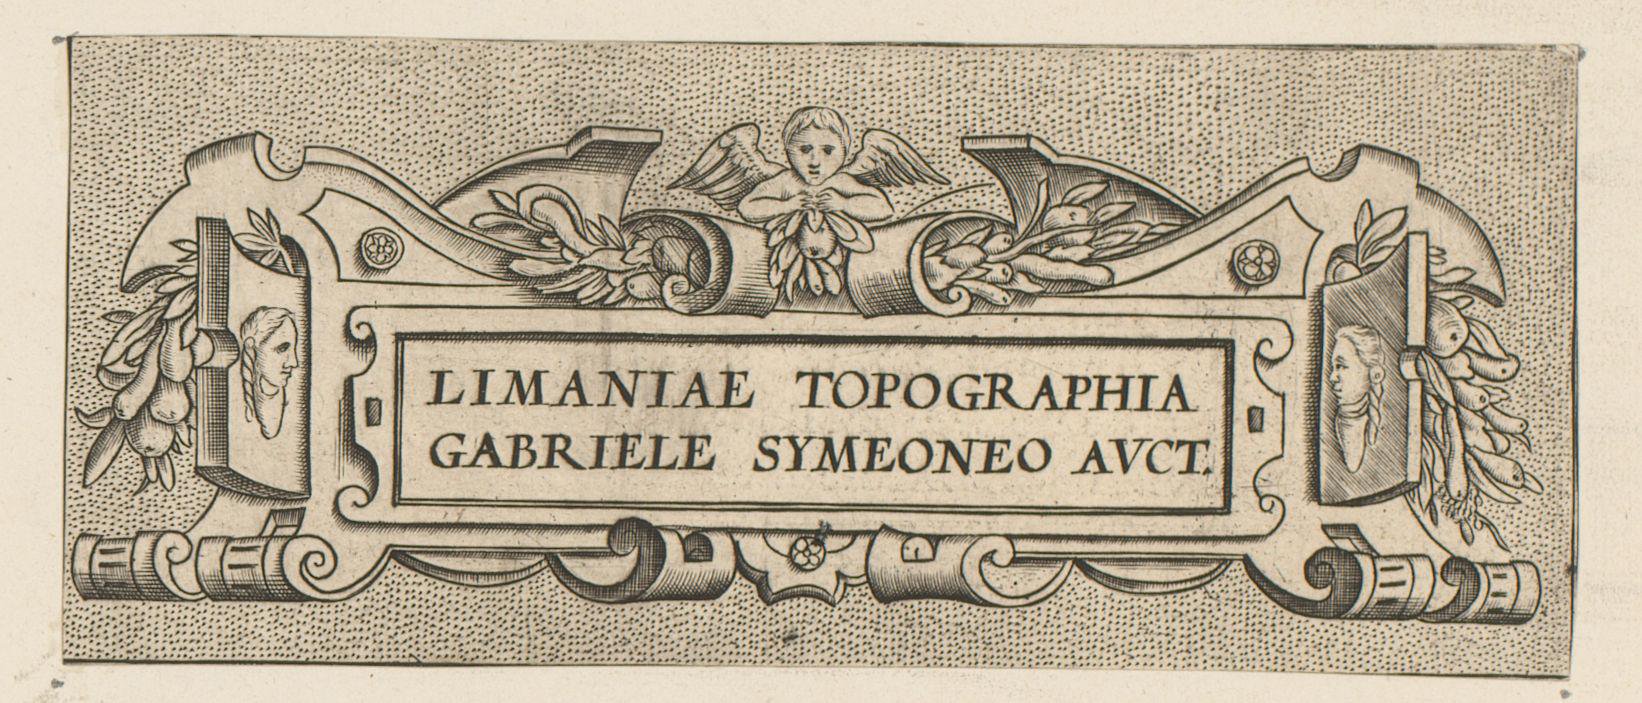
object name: ornament print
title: Limaniae Topographia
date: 1570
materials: paper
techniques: engraving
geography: antwerp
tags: scrollwork, strapwork ~ ornament, ornament ~ cartouche, cupids: 'amores', 'amoretti', 'putti'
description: Langwerpige rolwerkcartouche met trossen fruit en midden boven een putto. De cartouche is een fragment van een kaart van Limagne. De prent maakt deel uit van een album.